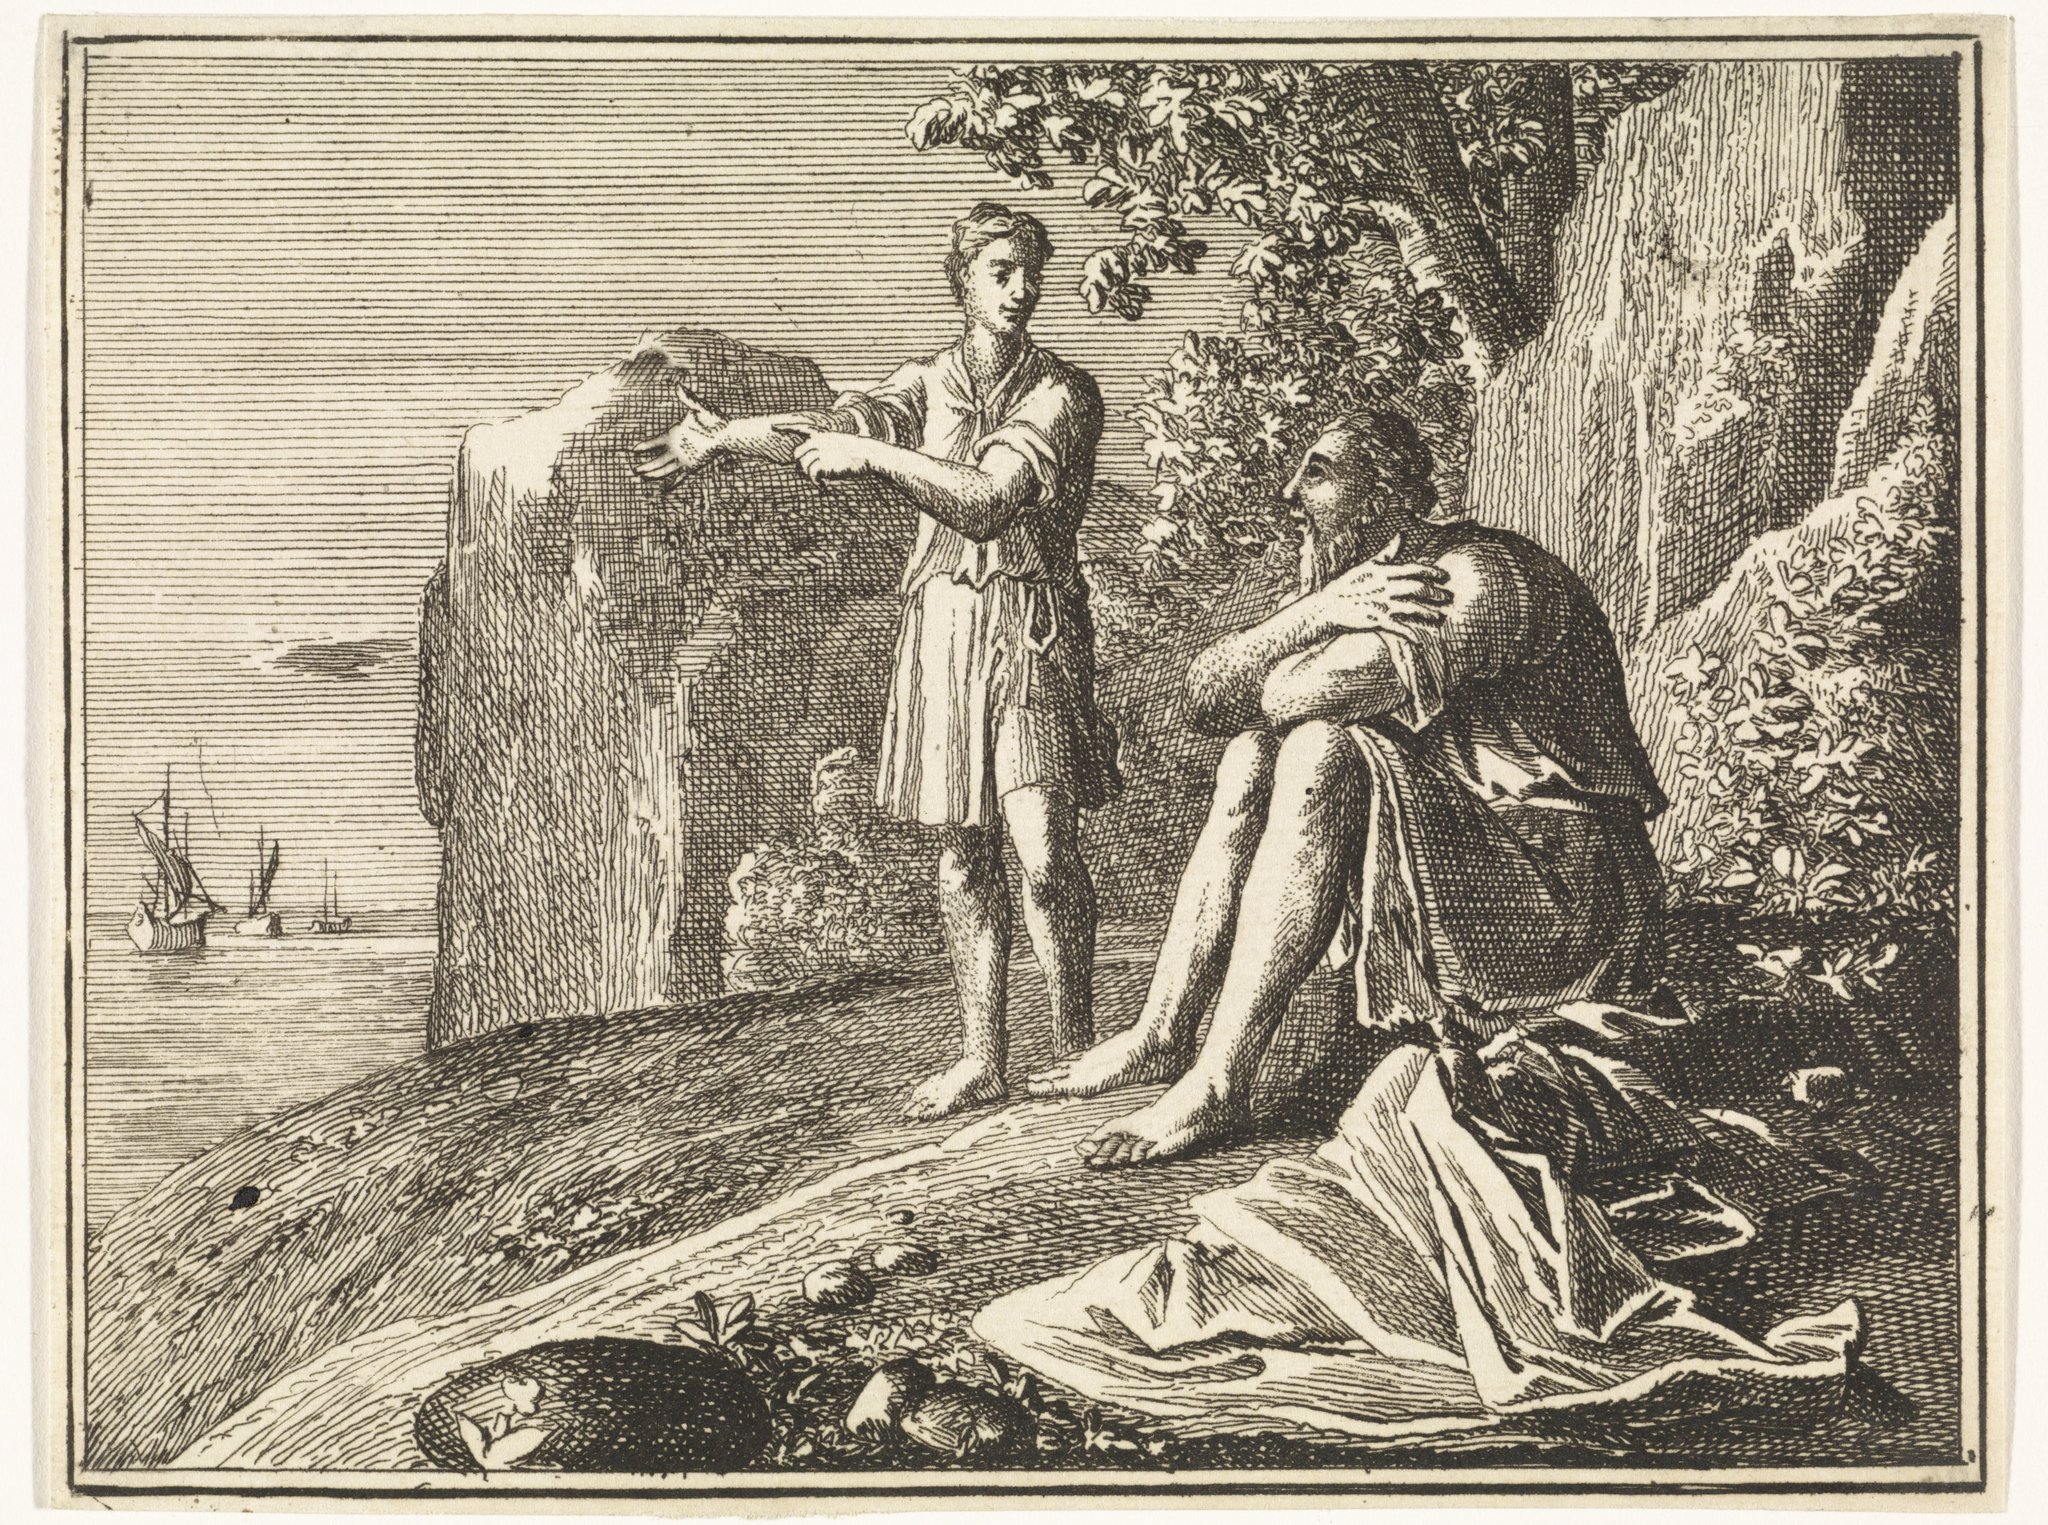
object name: print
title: De knecht van Elia ziet een kleine regenwolk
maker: caspar luyken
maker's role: draughtsman, print maker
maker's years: 1672-1708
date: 1712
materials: paper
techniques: etching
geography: amsterdam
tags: the servant reports he has seen a small cloud ~ story of elijah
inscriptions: collector's mark: Lugt 2228, number: ‘136’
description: Illustratie uit: Luyken, Jan. De schriftuurlyke geschiedenissen en gelykenissen van het Oude en Nieuwe Verbond, 2 delen. Amsterdam: Wed. Pieter Arentsz II en Cornelis van der Sys, 1712, dl. I.